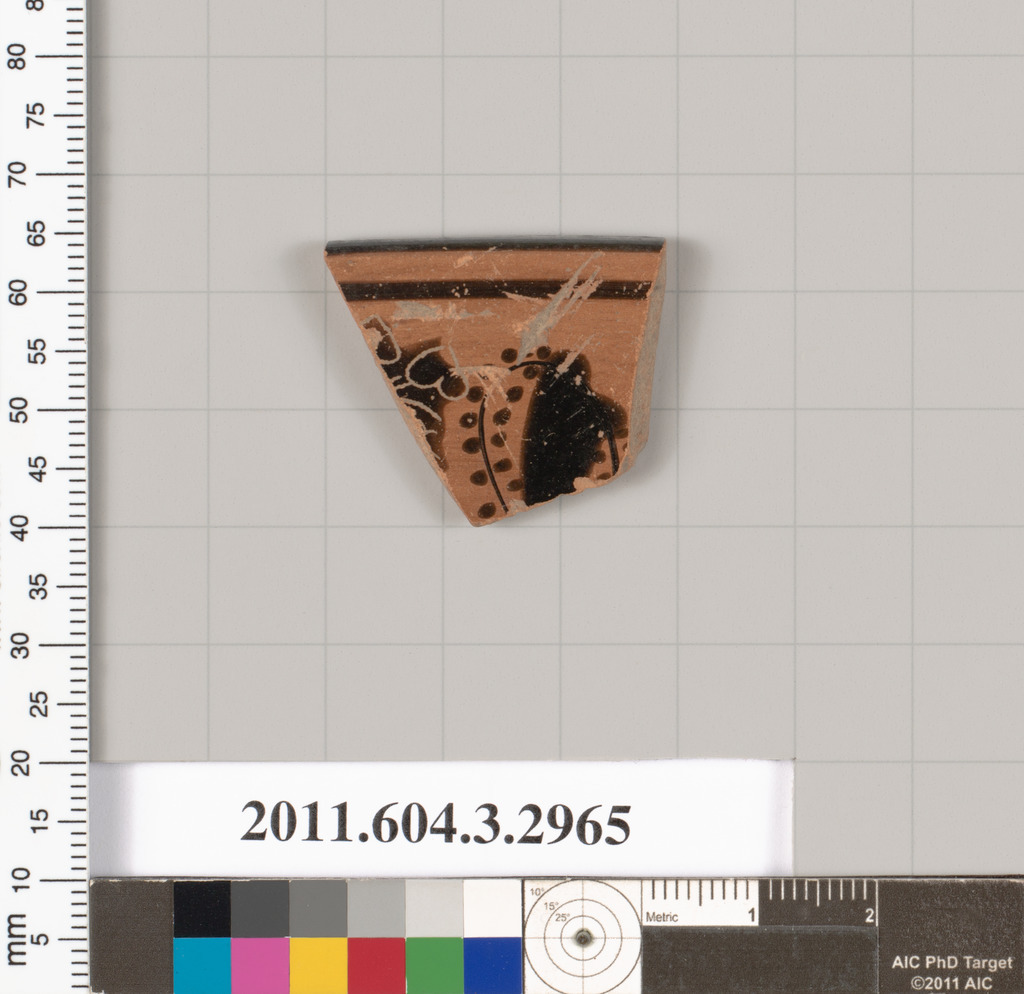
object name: kylix fragment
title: Terracotta rim fragment of a kylix (drinking cup)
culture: greek, attic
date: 534-468 BCE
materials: terracotta